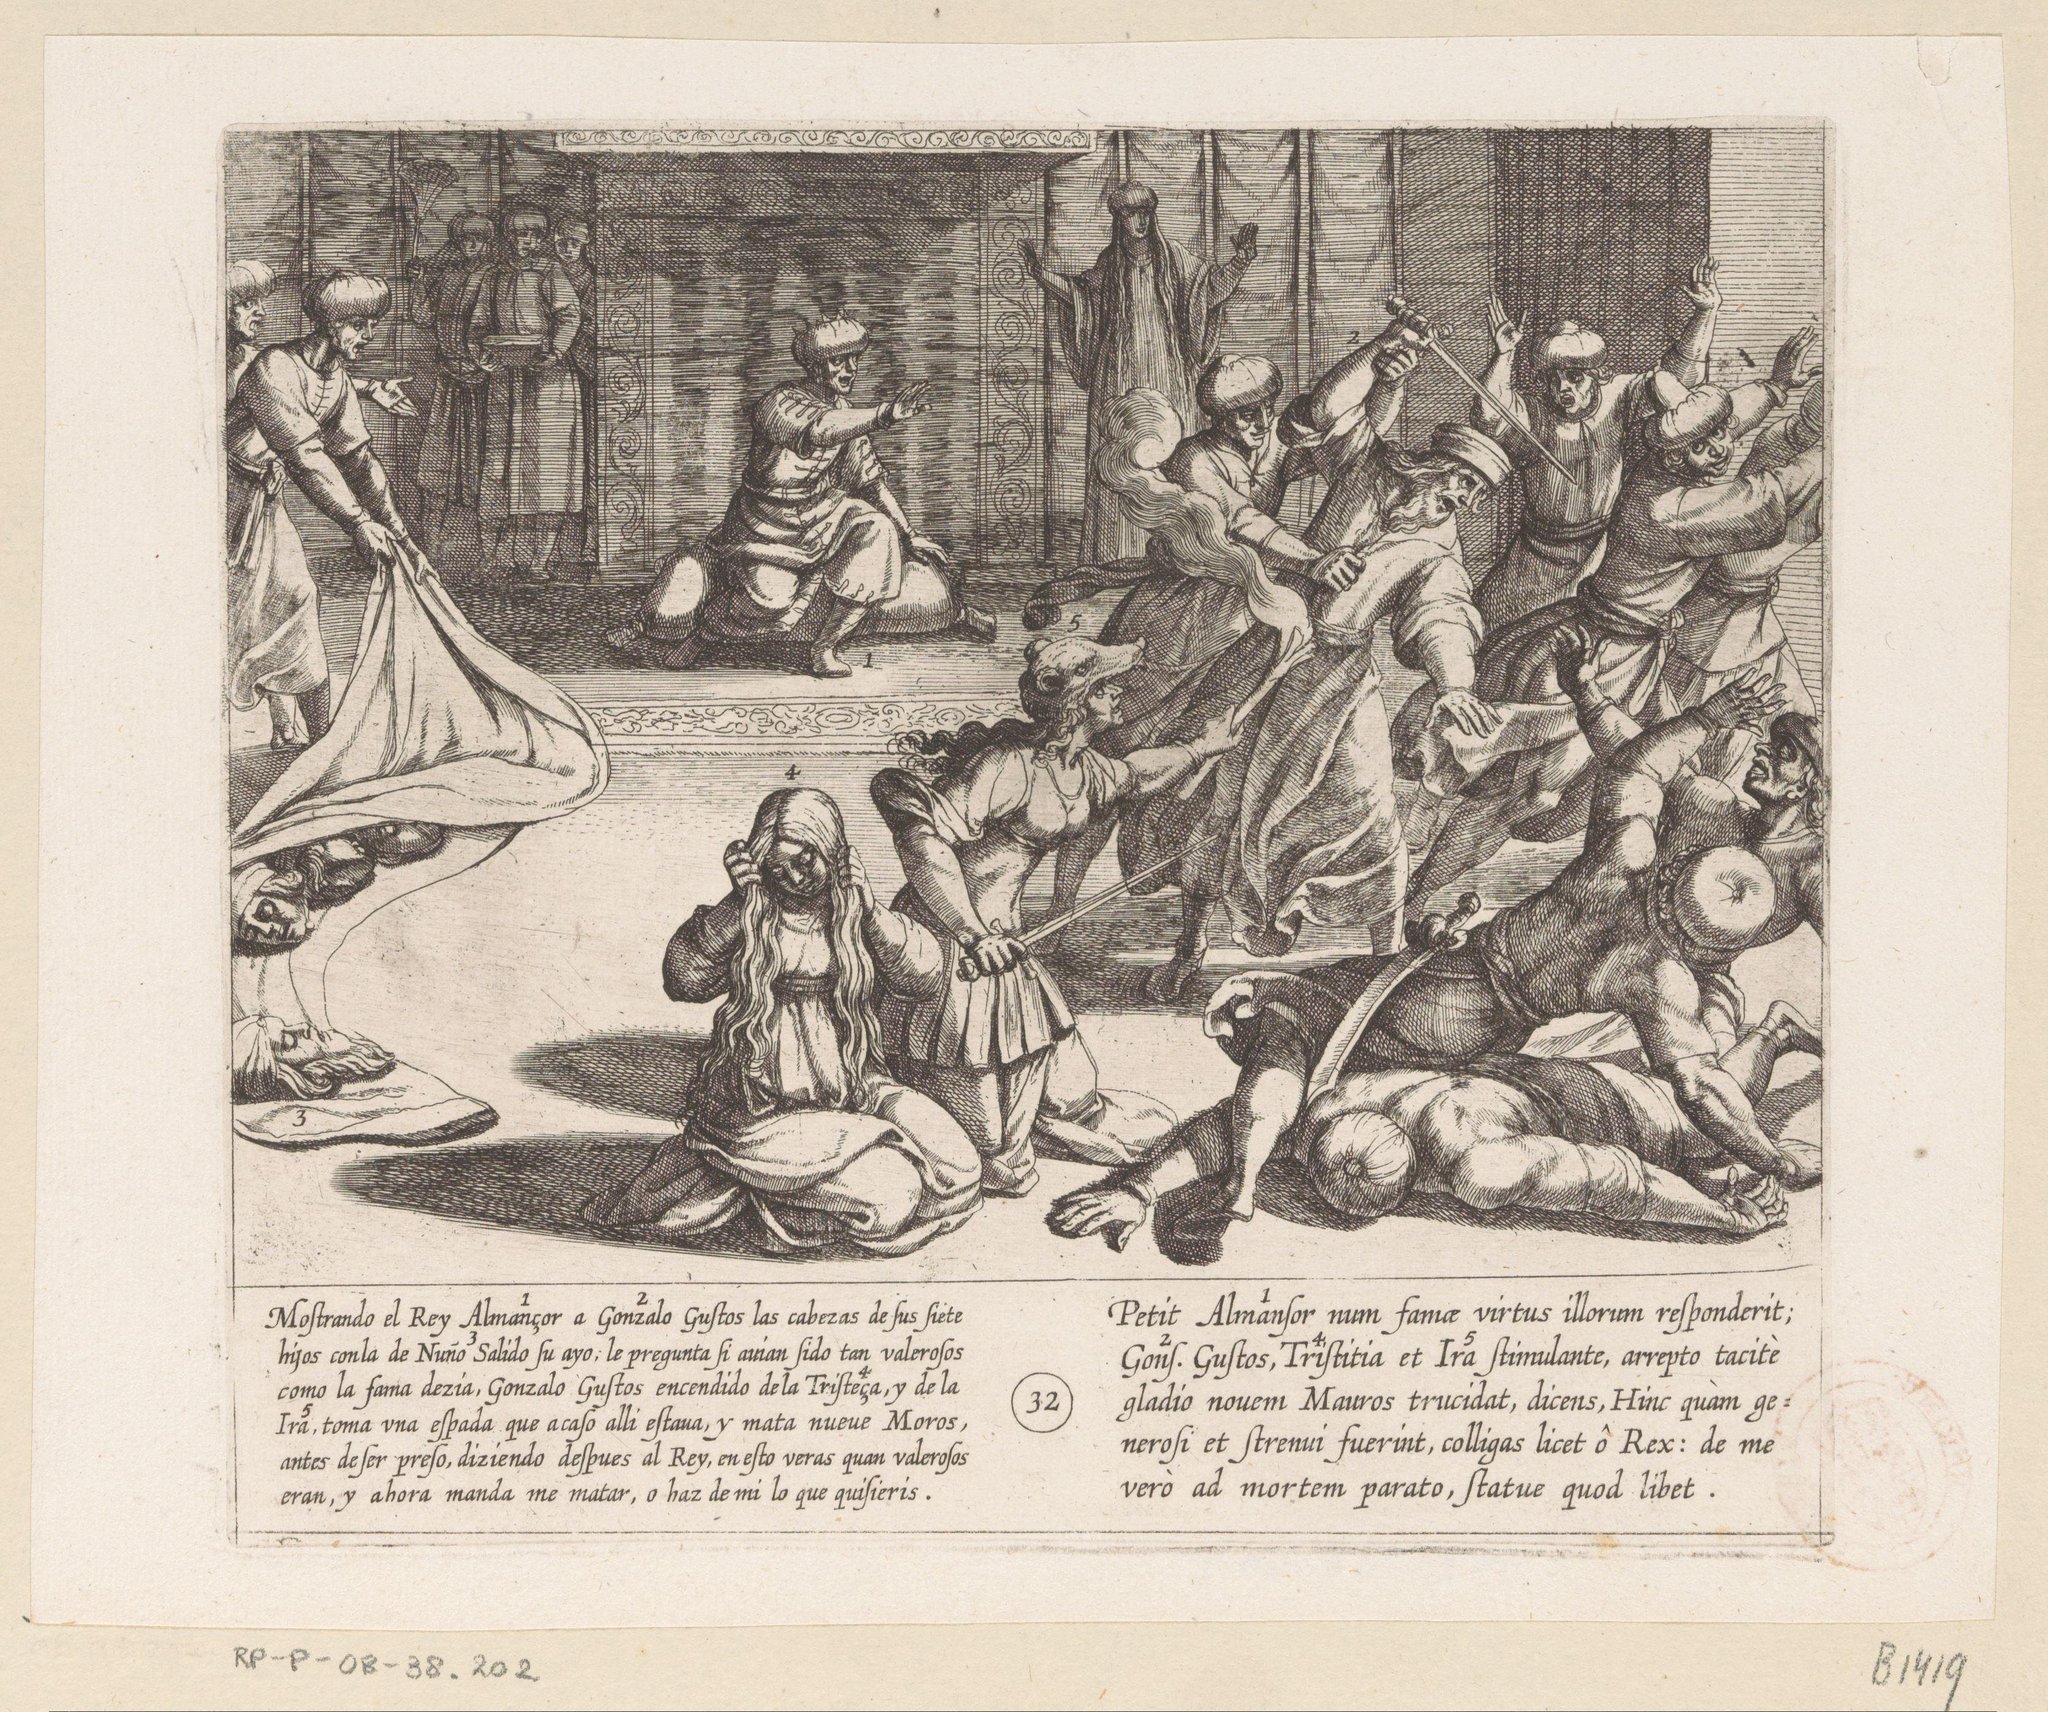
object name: print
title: De zeven infanten van Lara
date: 1612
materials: paper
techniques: etching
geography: italy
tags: murder, tales and fairy tales, murderer, blood-revenge, vendetta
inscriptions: collector's mark: Lugt 240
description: Deze prent maakt deel uit van een reeks van 40 prenten (+ titelprent) met voorstellingen uit het volksverhaal over de zeven infanten van Lara.